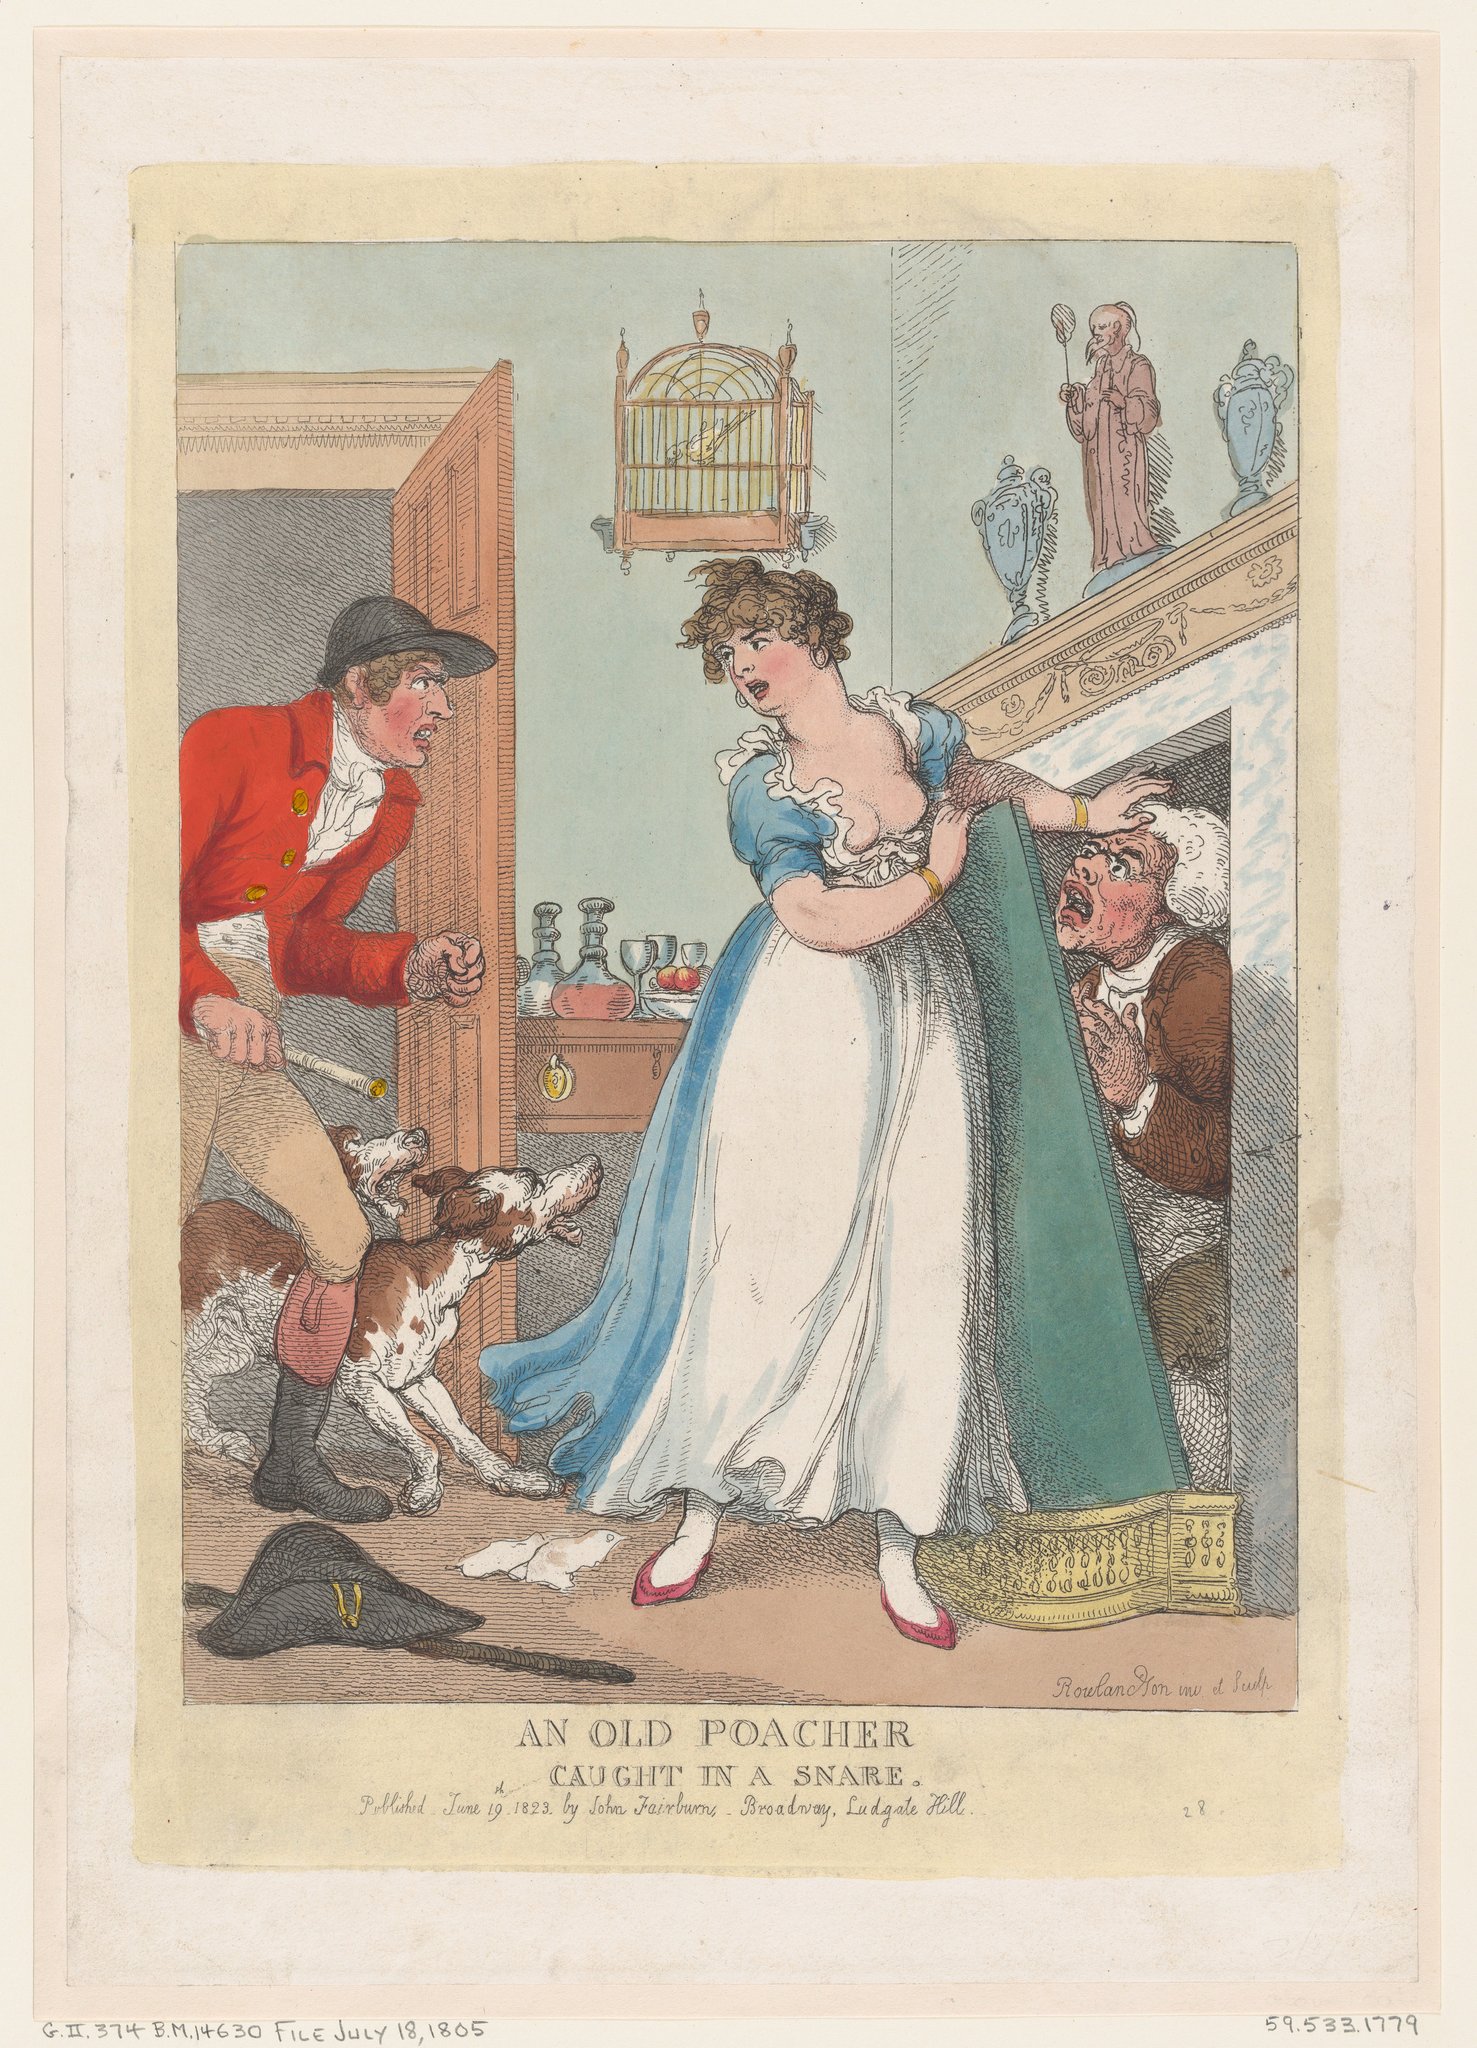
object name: print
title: An Old Poacher Caught in a Snare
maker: thomas rowlandson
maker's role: artist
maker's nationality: british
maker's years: 1757-1827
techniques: etching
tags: satire,anger,fear,men,women,dogs